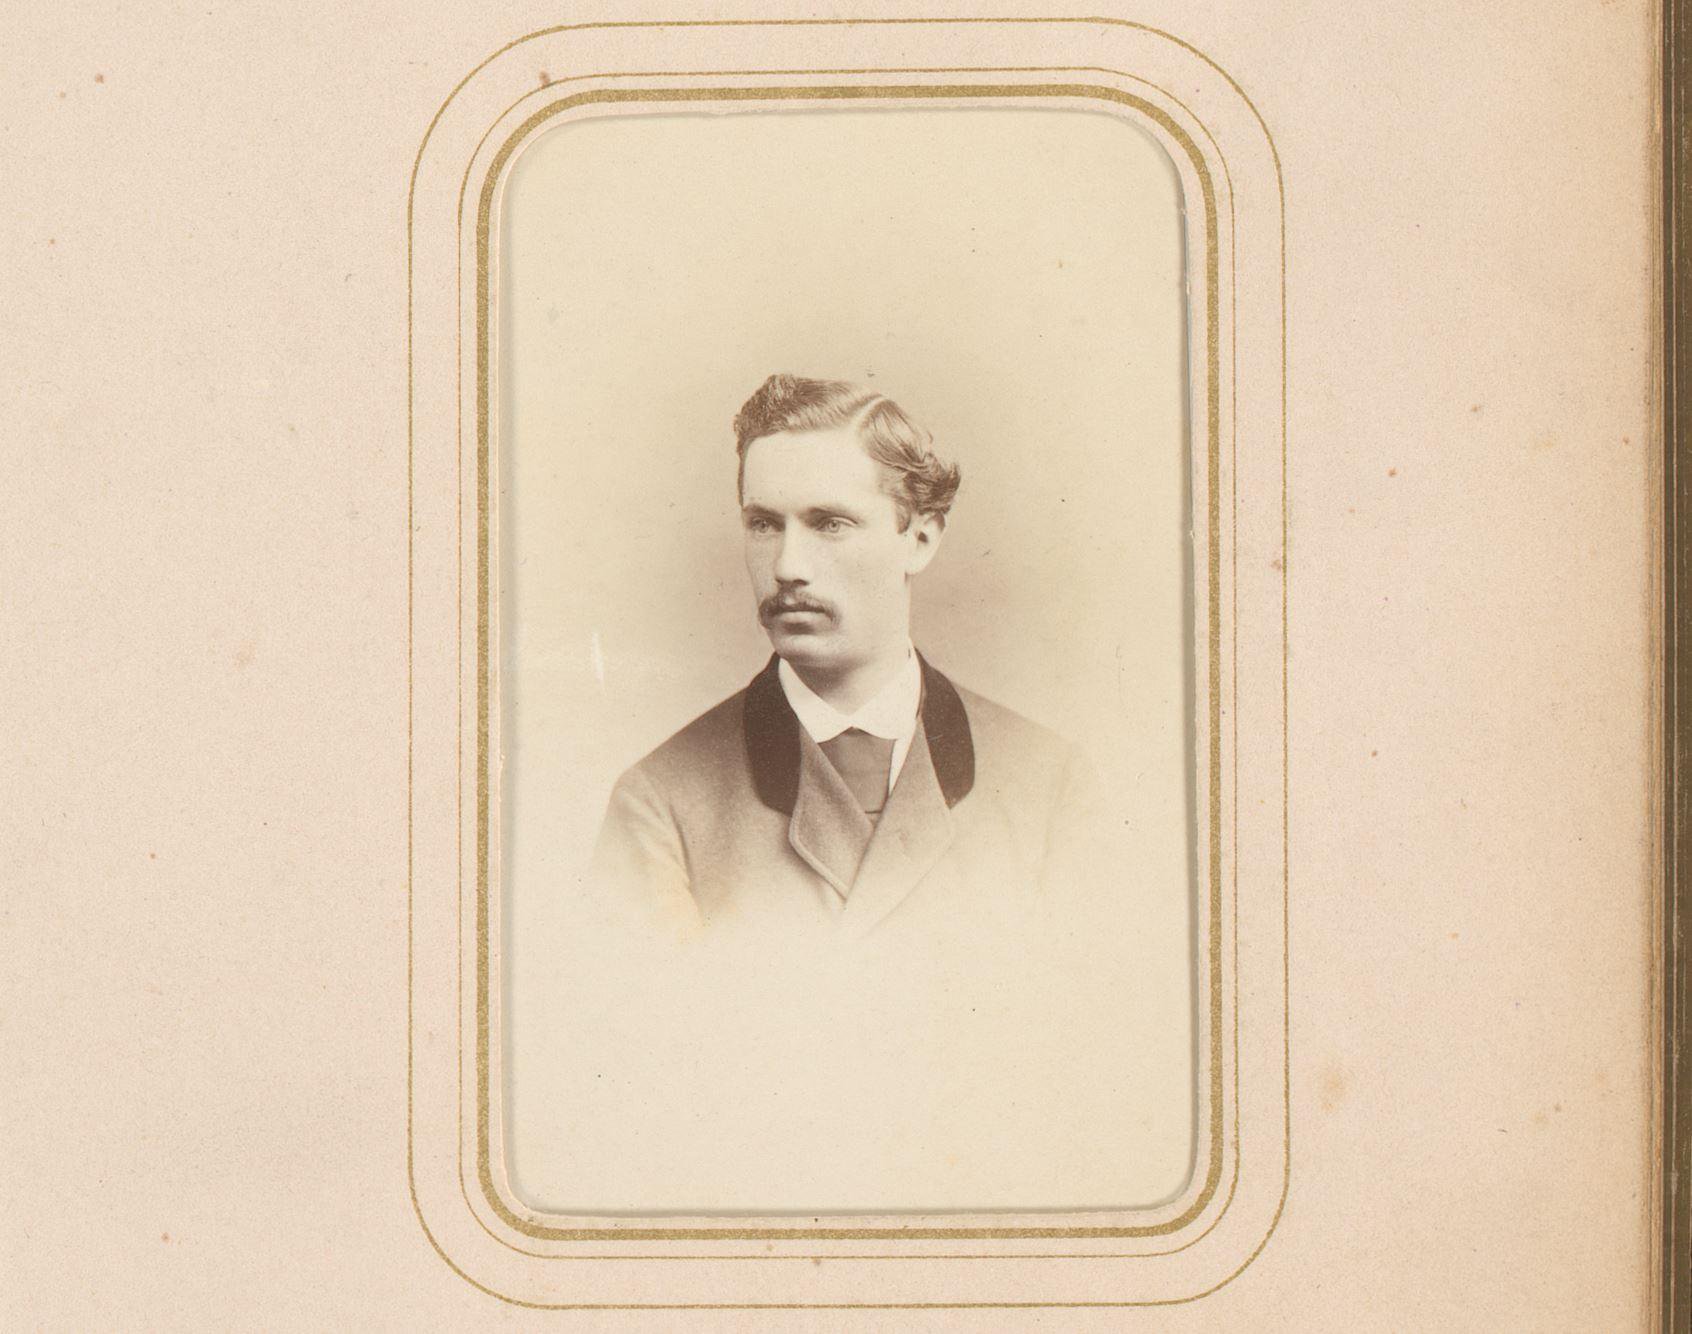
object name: photograph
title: Portret van een man met snor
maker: augustin aimé joseph lejeune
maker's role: fotograaf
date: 1860-1900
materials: cardboard, photographic support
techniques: albumen print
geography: paris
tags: moustache, historical persons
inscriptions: name: ‘Gri[...] Hum[pley]’, inscription: ‘Le Jeune/ Photographe Breveté/ de S. A. le Prince Impérial/ ANCIENNE Mon LEVITSKY’